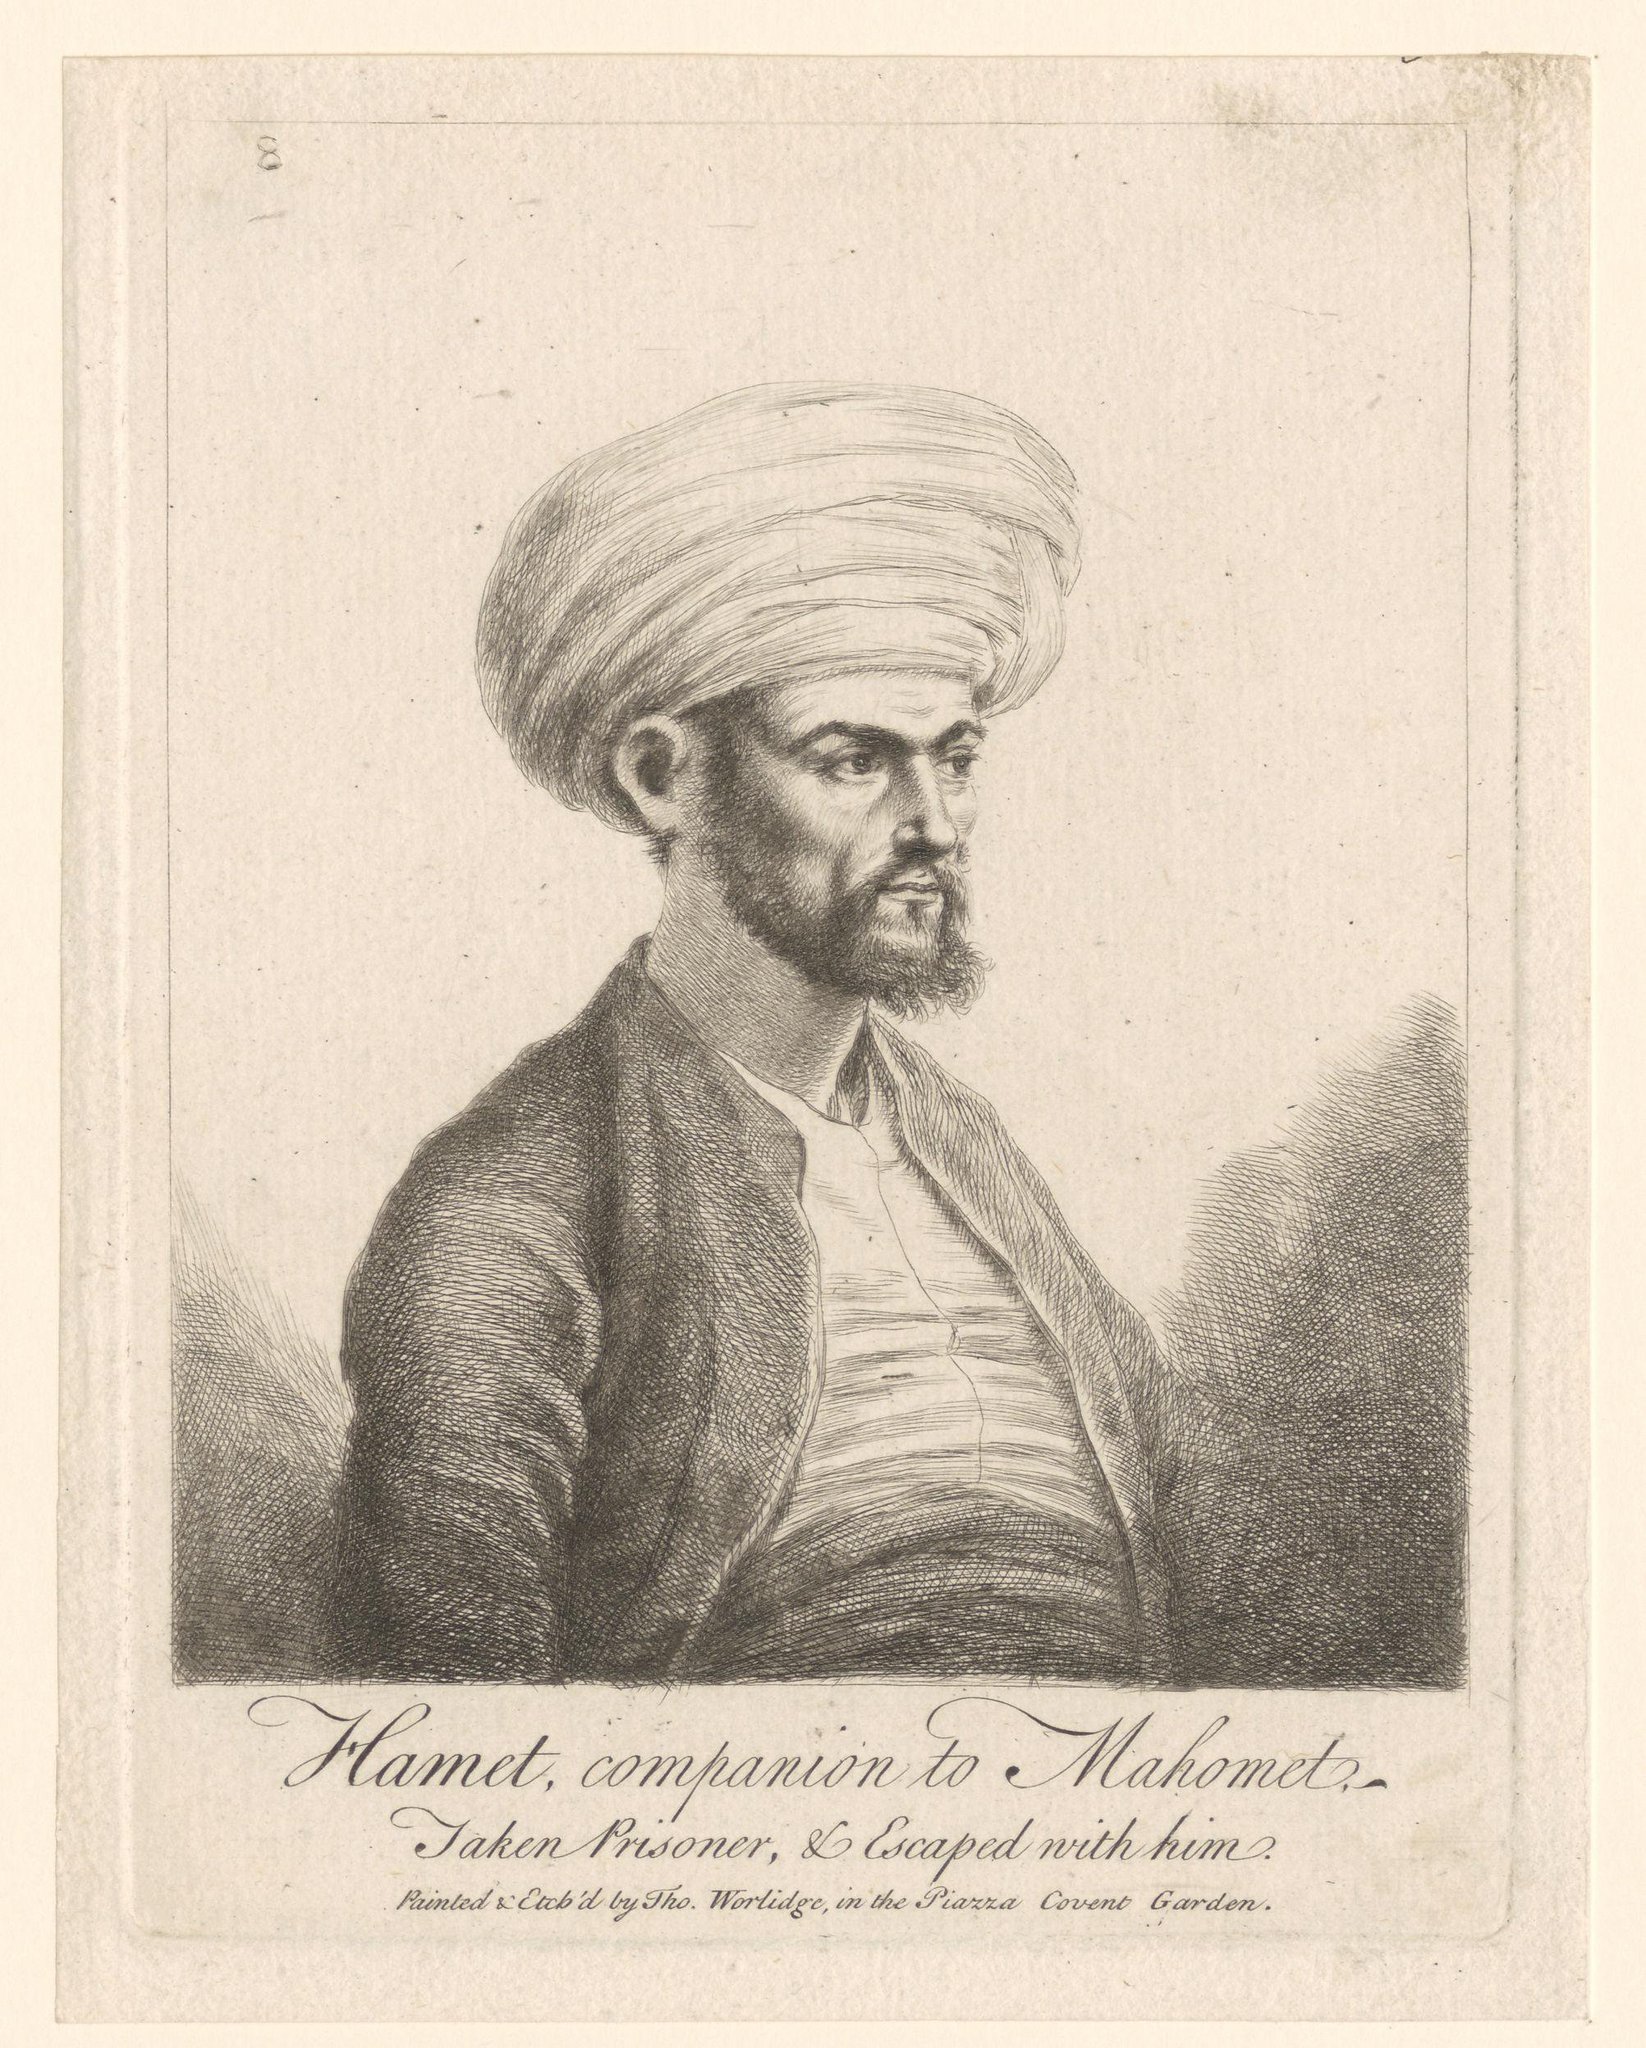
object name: print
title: Portret van Hamet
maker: thomas worlidge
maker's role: print maker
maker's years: 1700-1766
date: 1710-1766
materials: paper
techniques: drypoint, etching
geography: london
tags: historical persons, head-gear: turban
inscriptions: collector's mark: Lugt 2760, collector's mark: Lugt 2228